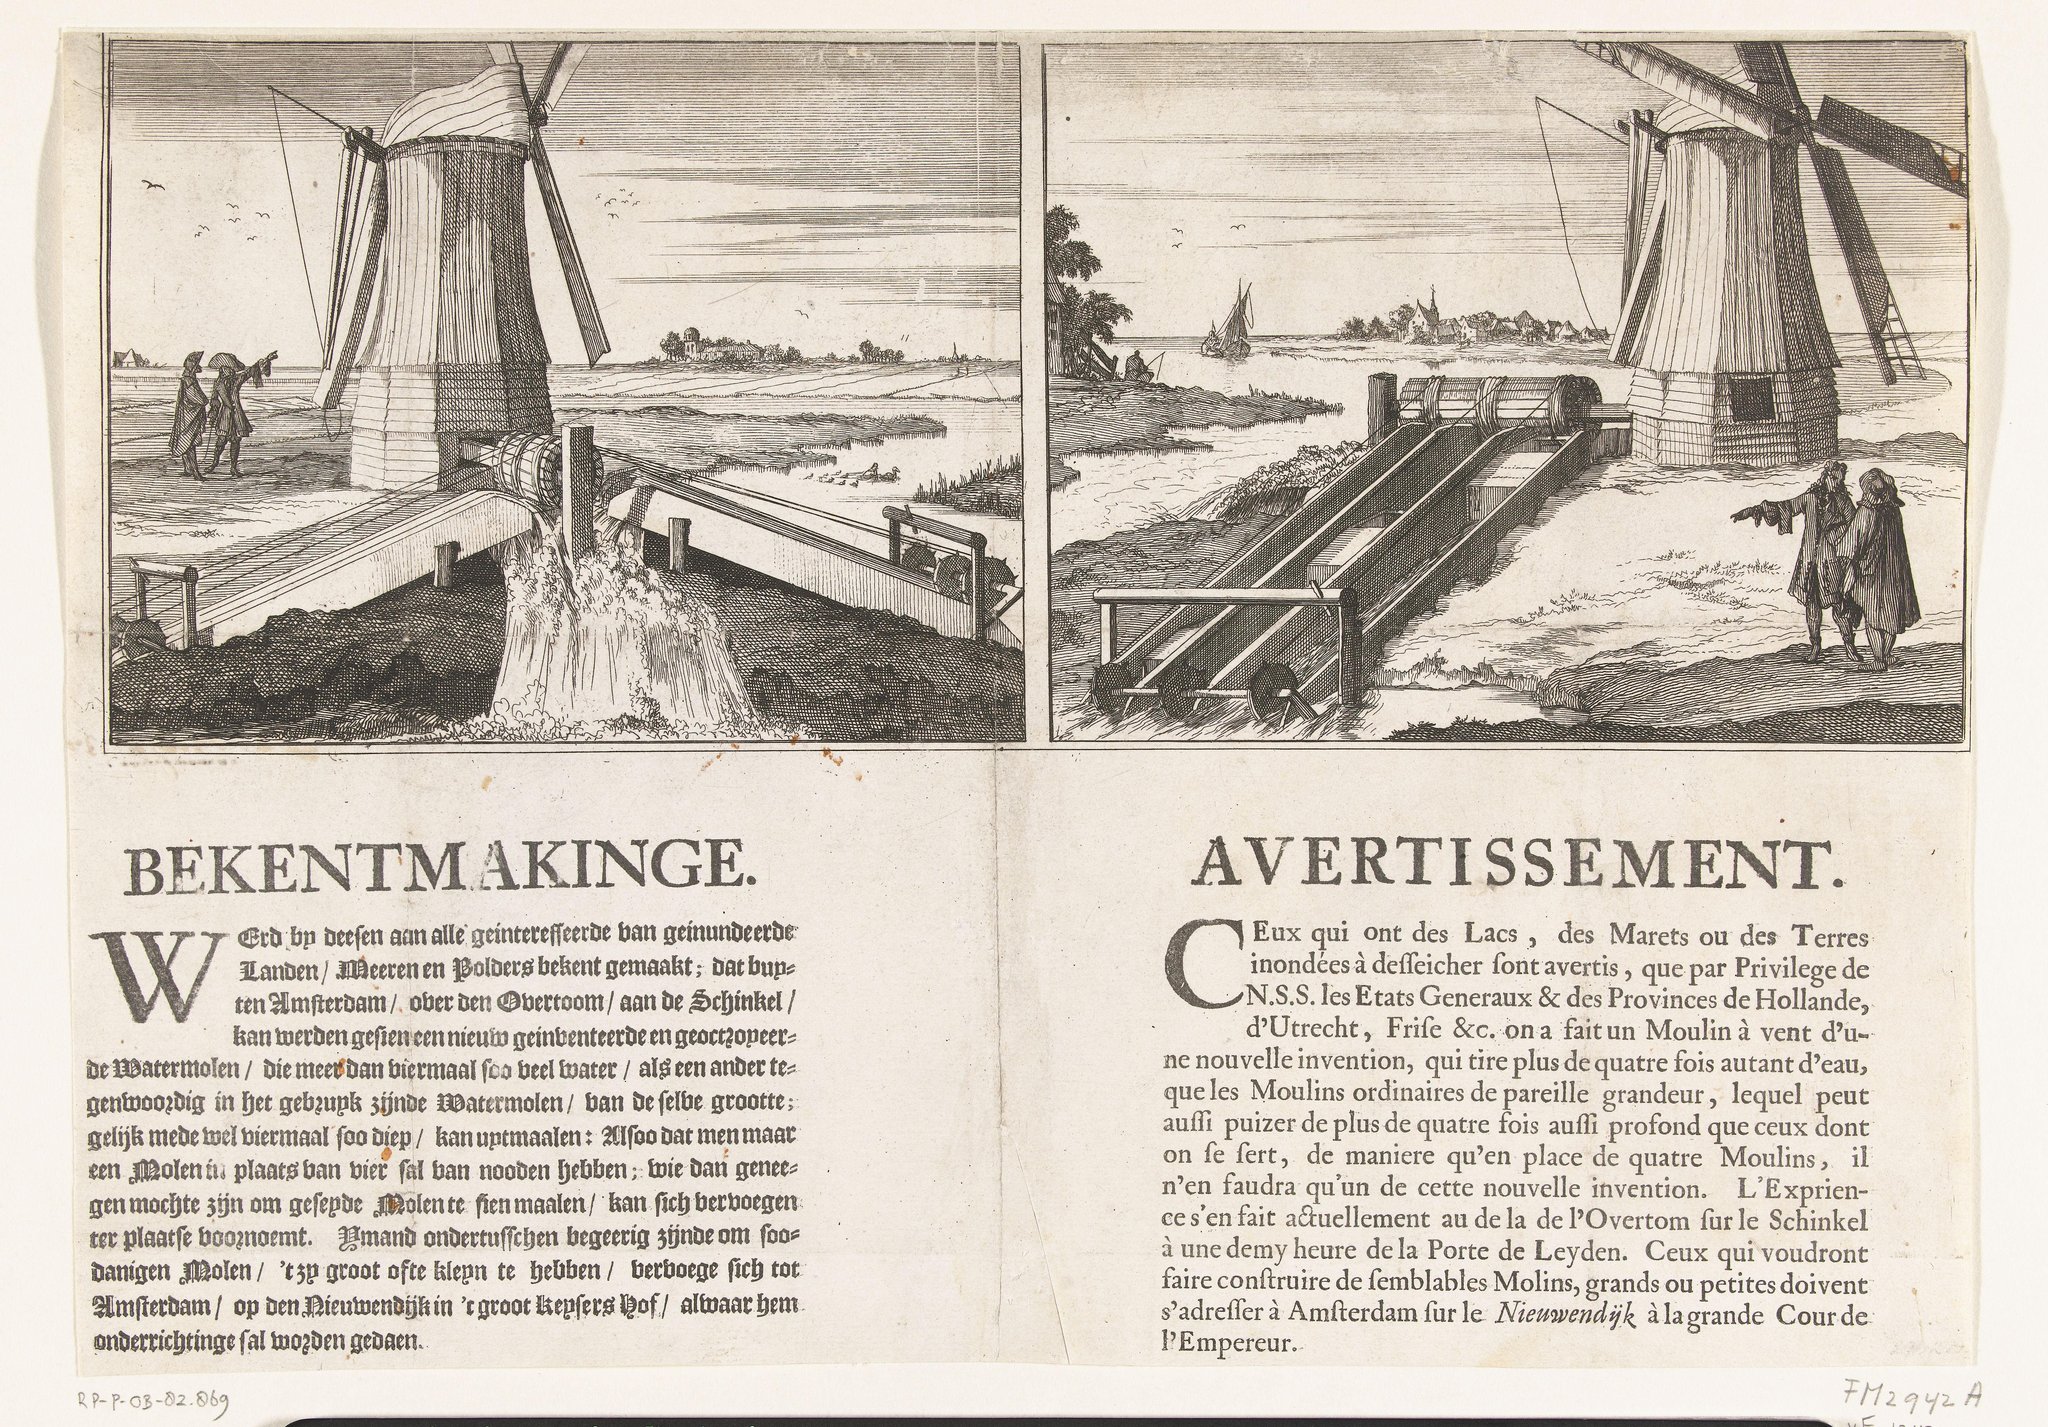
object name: print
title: Bekendmaking van een nieuw soort watermolen, ca. 1691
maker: caspar luyken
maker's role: draughtsman, print maker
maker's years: 1672-1708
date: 1690-1691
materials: paper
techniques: etching, letterpress printing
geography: northern netherlands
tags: advertisement, notice, windmill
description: Blad met de bekendmaking of advertentie en twee voorstellingen van een nieuw soort watermolen die veel efficienter kan bemalen, te zien aan de Schinkel te Amsterdam, ca. 1691. Met teksten in het Nederlands en Frans. Linksonder sporen van de weggepolijste naam van de maker.